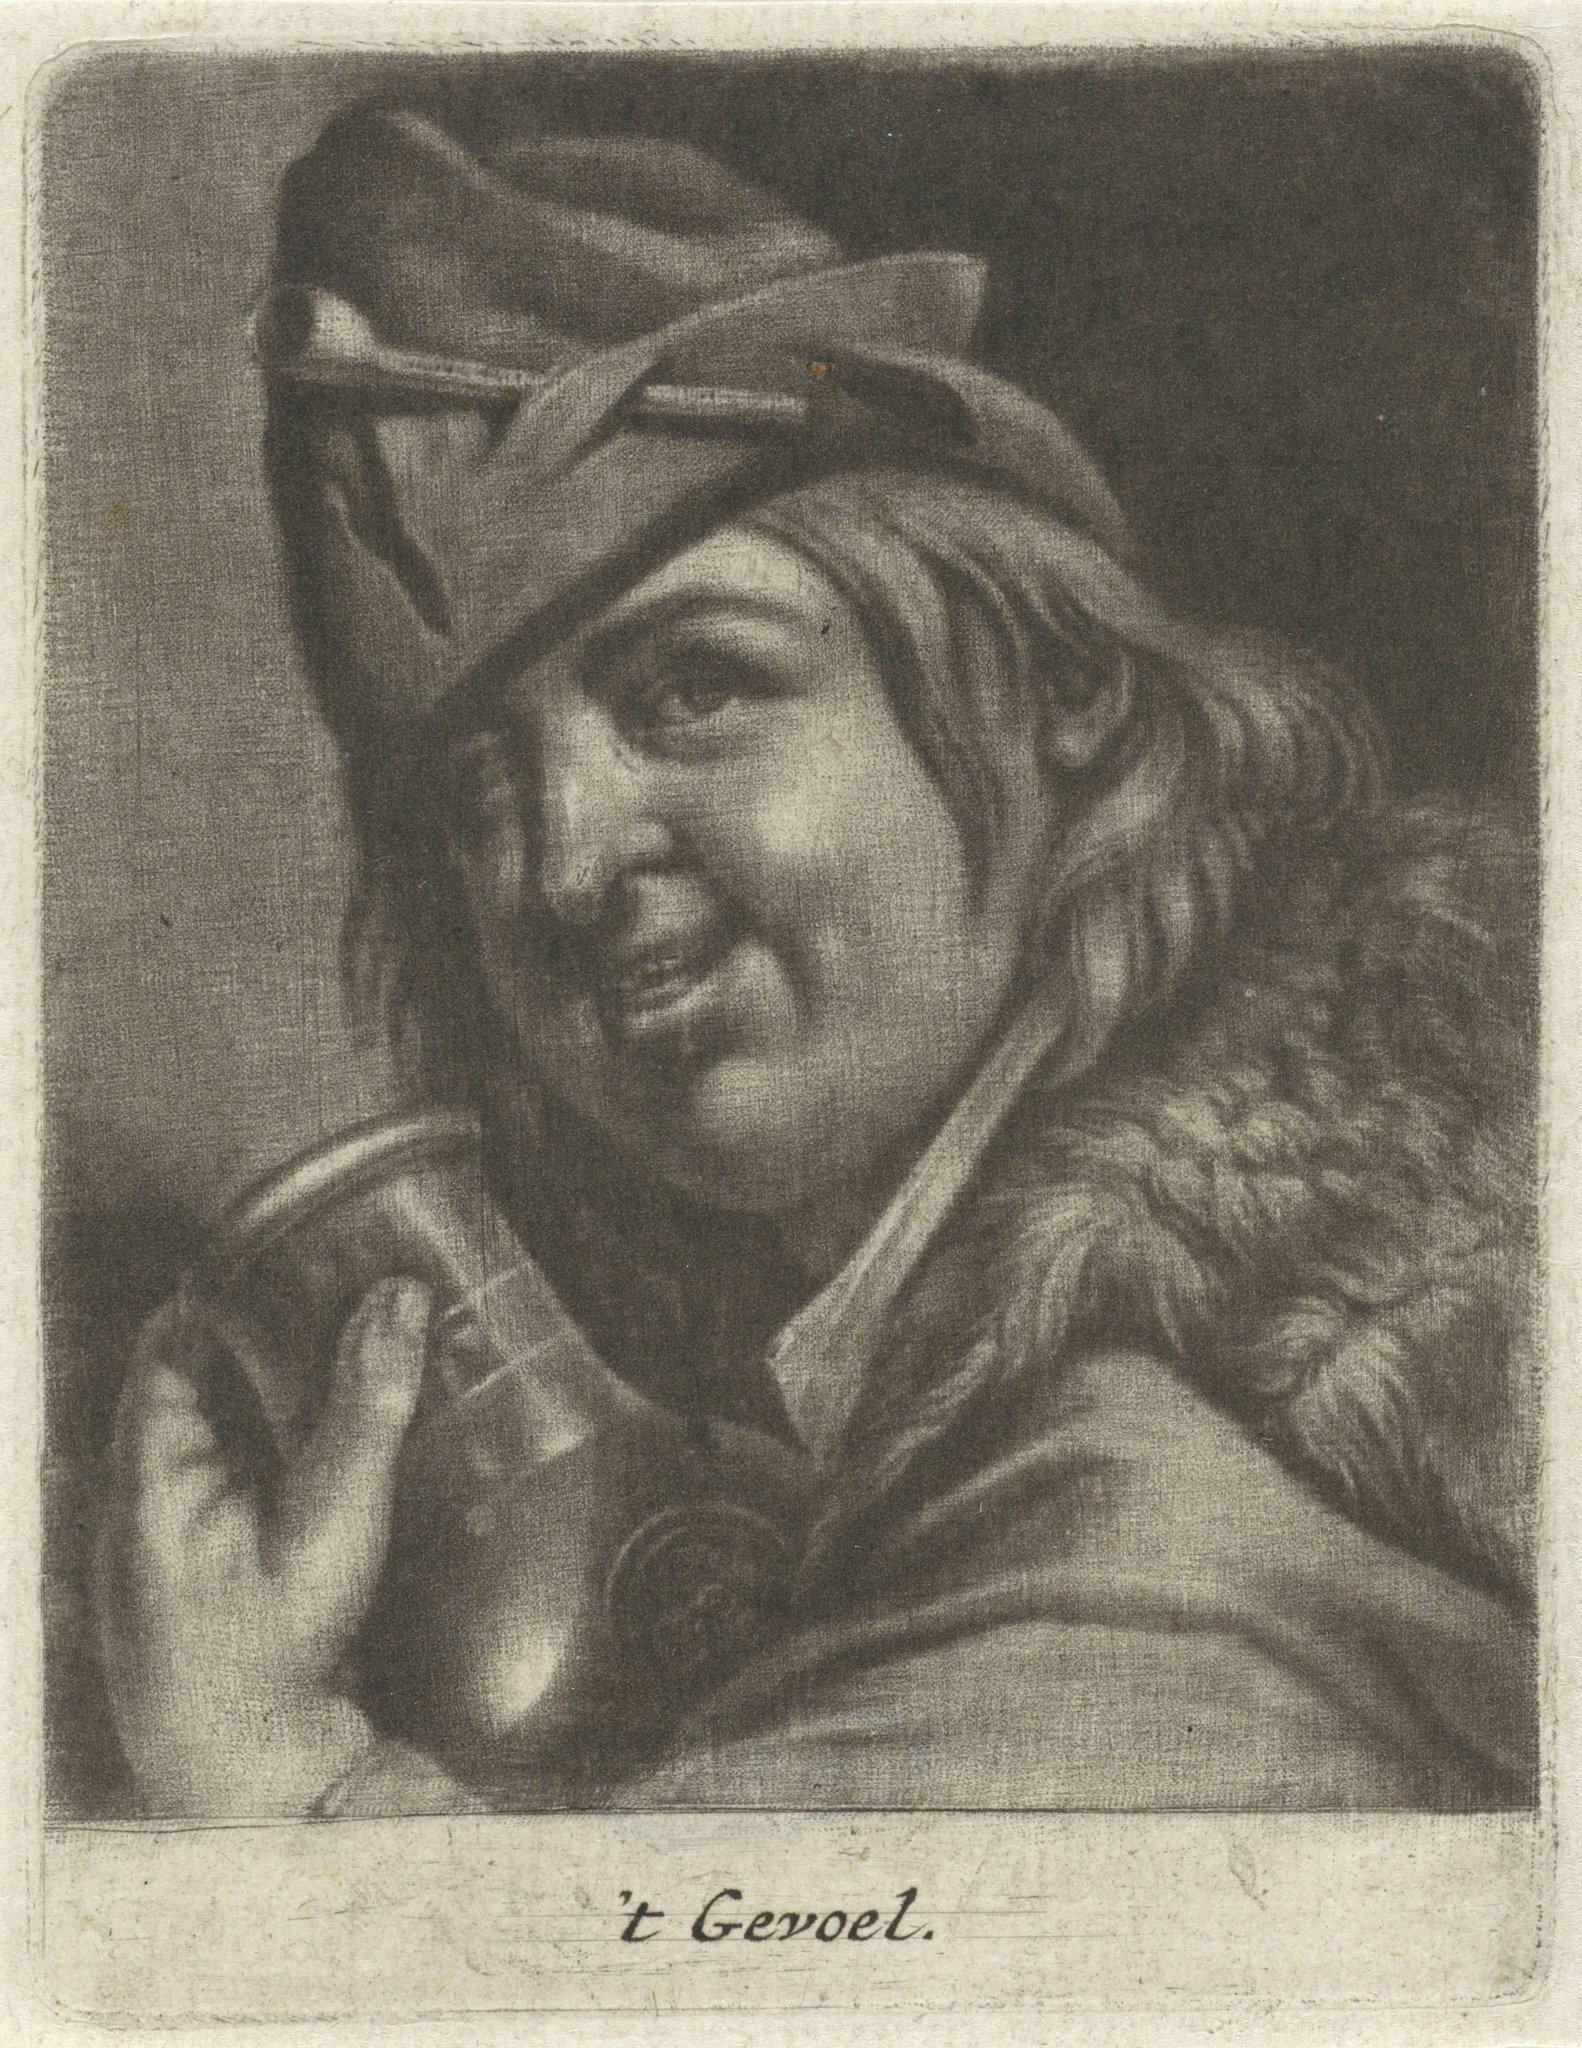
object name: print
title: De vijf zintuigen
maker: jacob toorenvliet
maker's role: draughtsman, painter, print maker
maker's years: 1640-1719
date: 1651-1719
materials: paper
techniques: mezzotint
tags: jar, jug (used as drinking-vessel), feeling (one of the five senses)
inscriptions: collector's mark: Lugt 2228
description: Een man met een kruik en in zijn muts een pijpje. De prent maakt deel uit van een serie van vijf prenten met de vijf zintuigen.